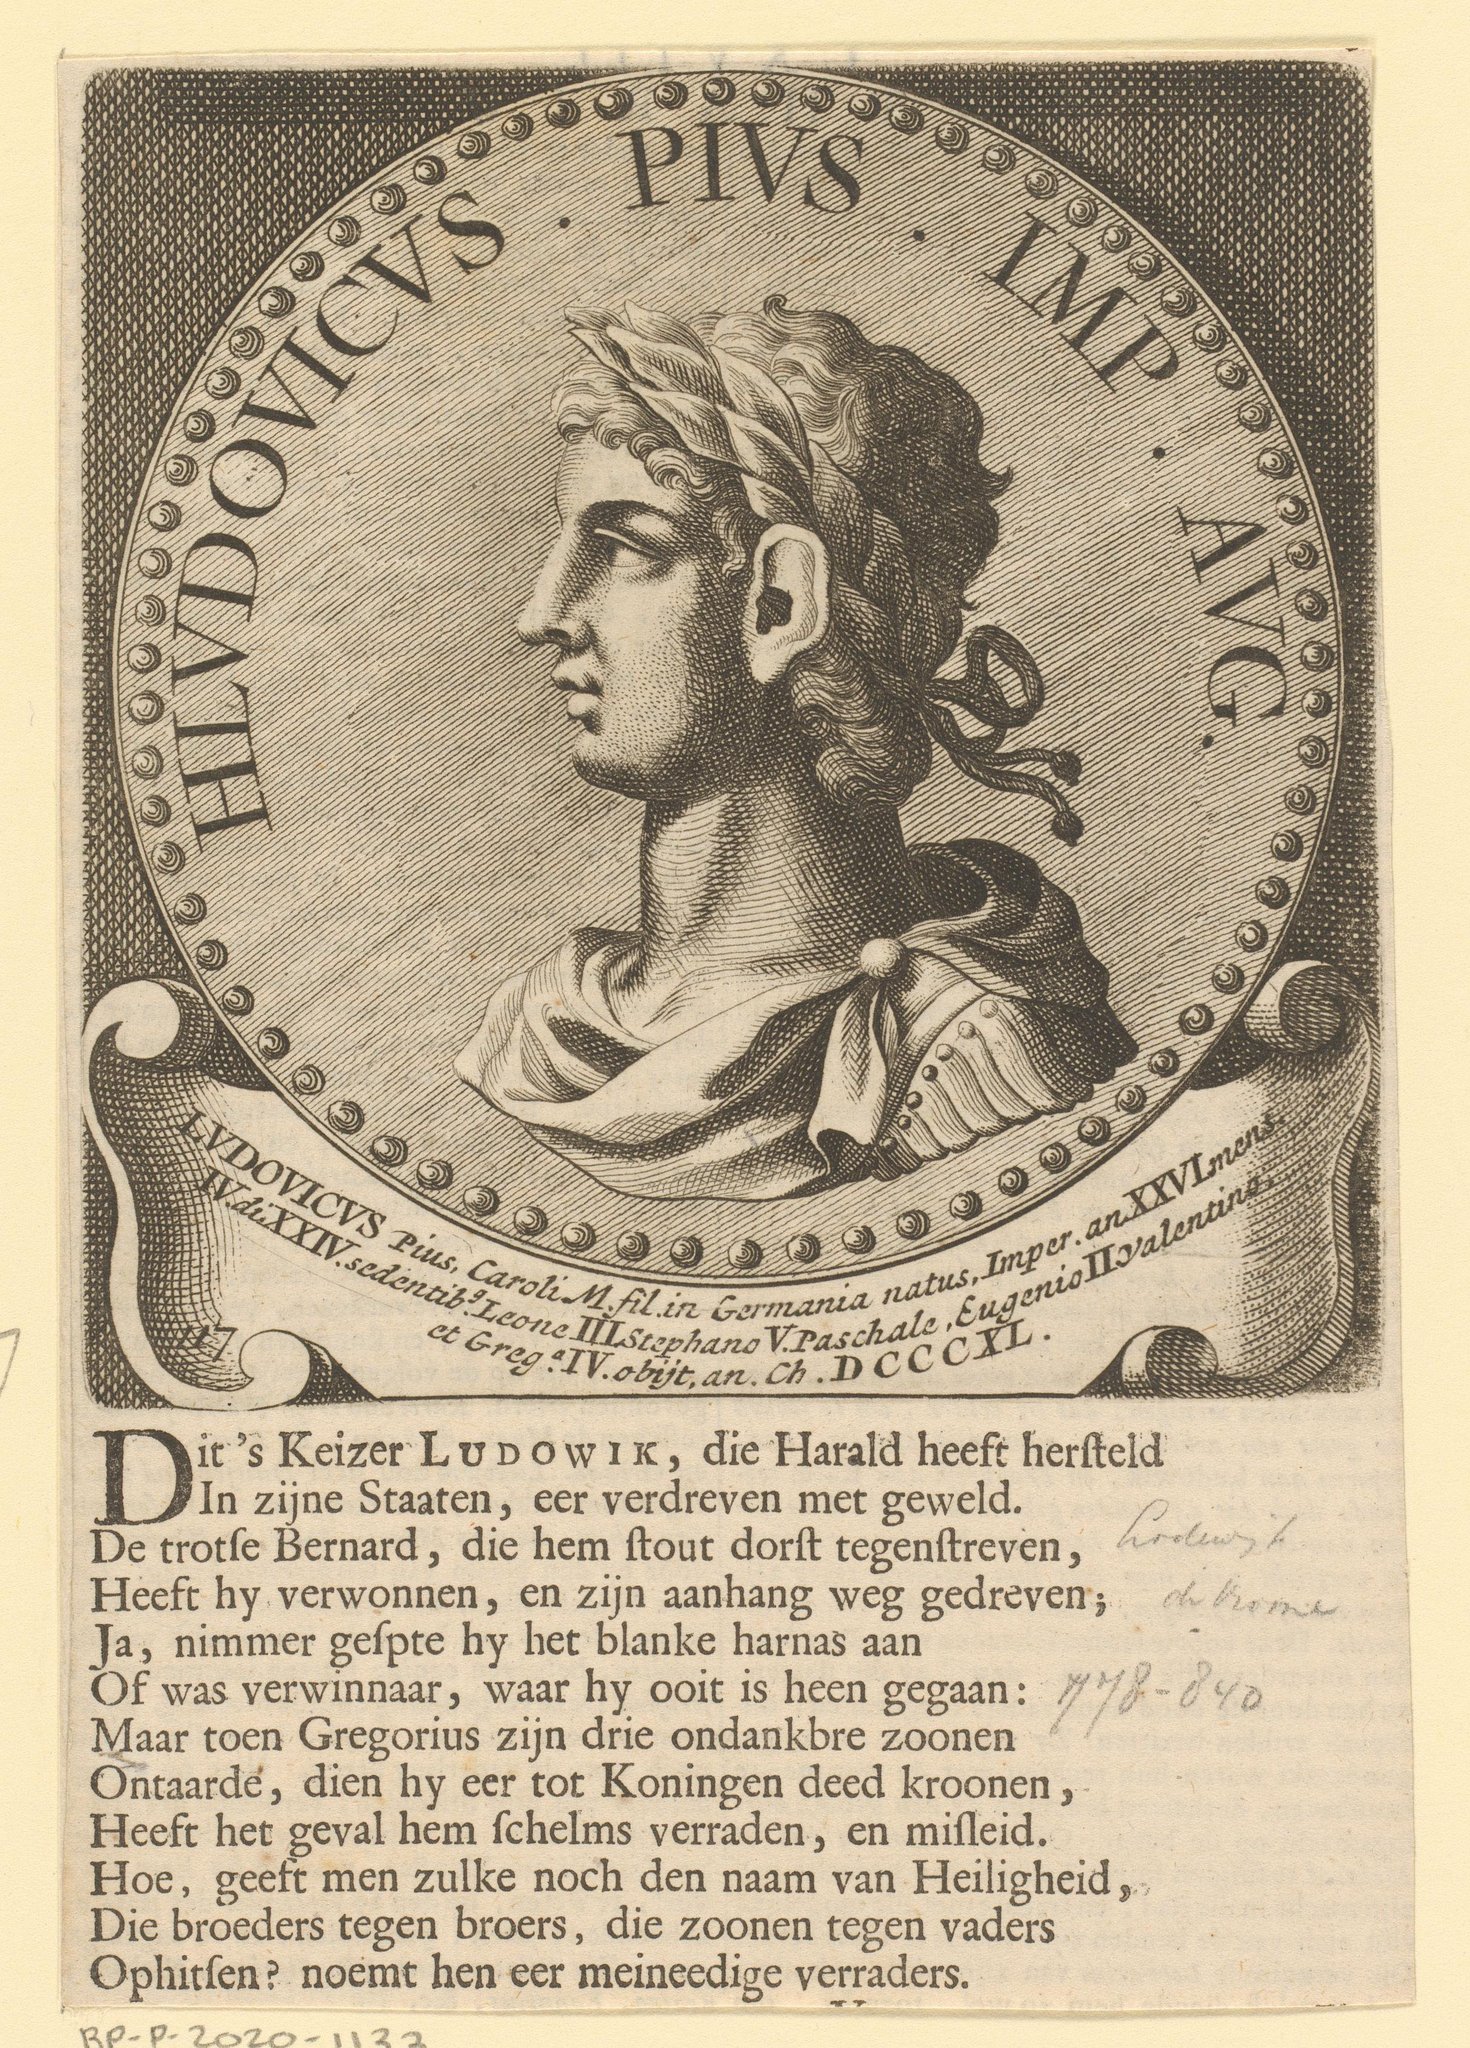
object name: book illustration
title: Portret van Lodewijk de Vrome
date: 1697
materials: paper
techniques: engraving, etching, letterpress printing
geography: utrecht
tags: france, historical persons, emperor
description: Prent uit: Bogaert, Abraham. De Roomsche monarchy, vertoont in de muntbeelden der westersche en oostersche keizeren (...). Utrecht: François Halma en Willem van de Water, 1697, p. 341. Eerste staat verschenen in een grotere prent met twaalf portretten, gedateerd 1695.